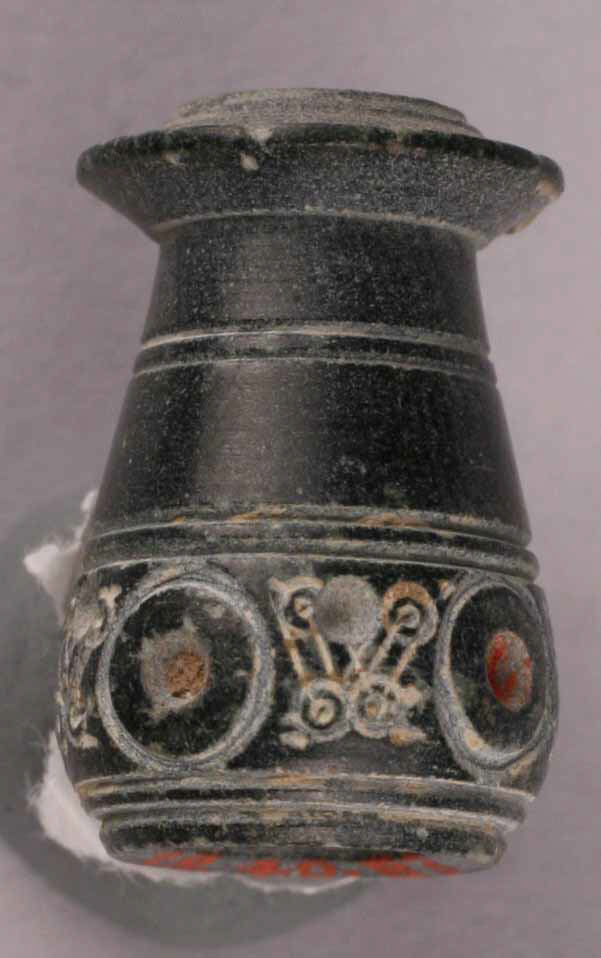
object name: button or bead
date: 701-1000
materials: paint, stone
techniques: incising, inlay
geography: iran